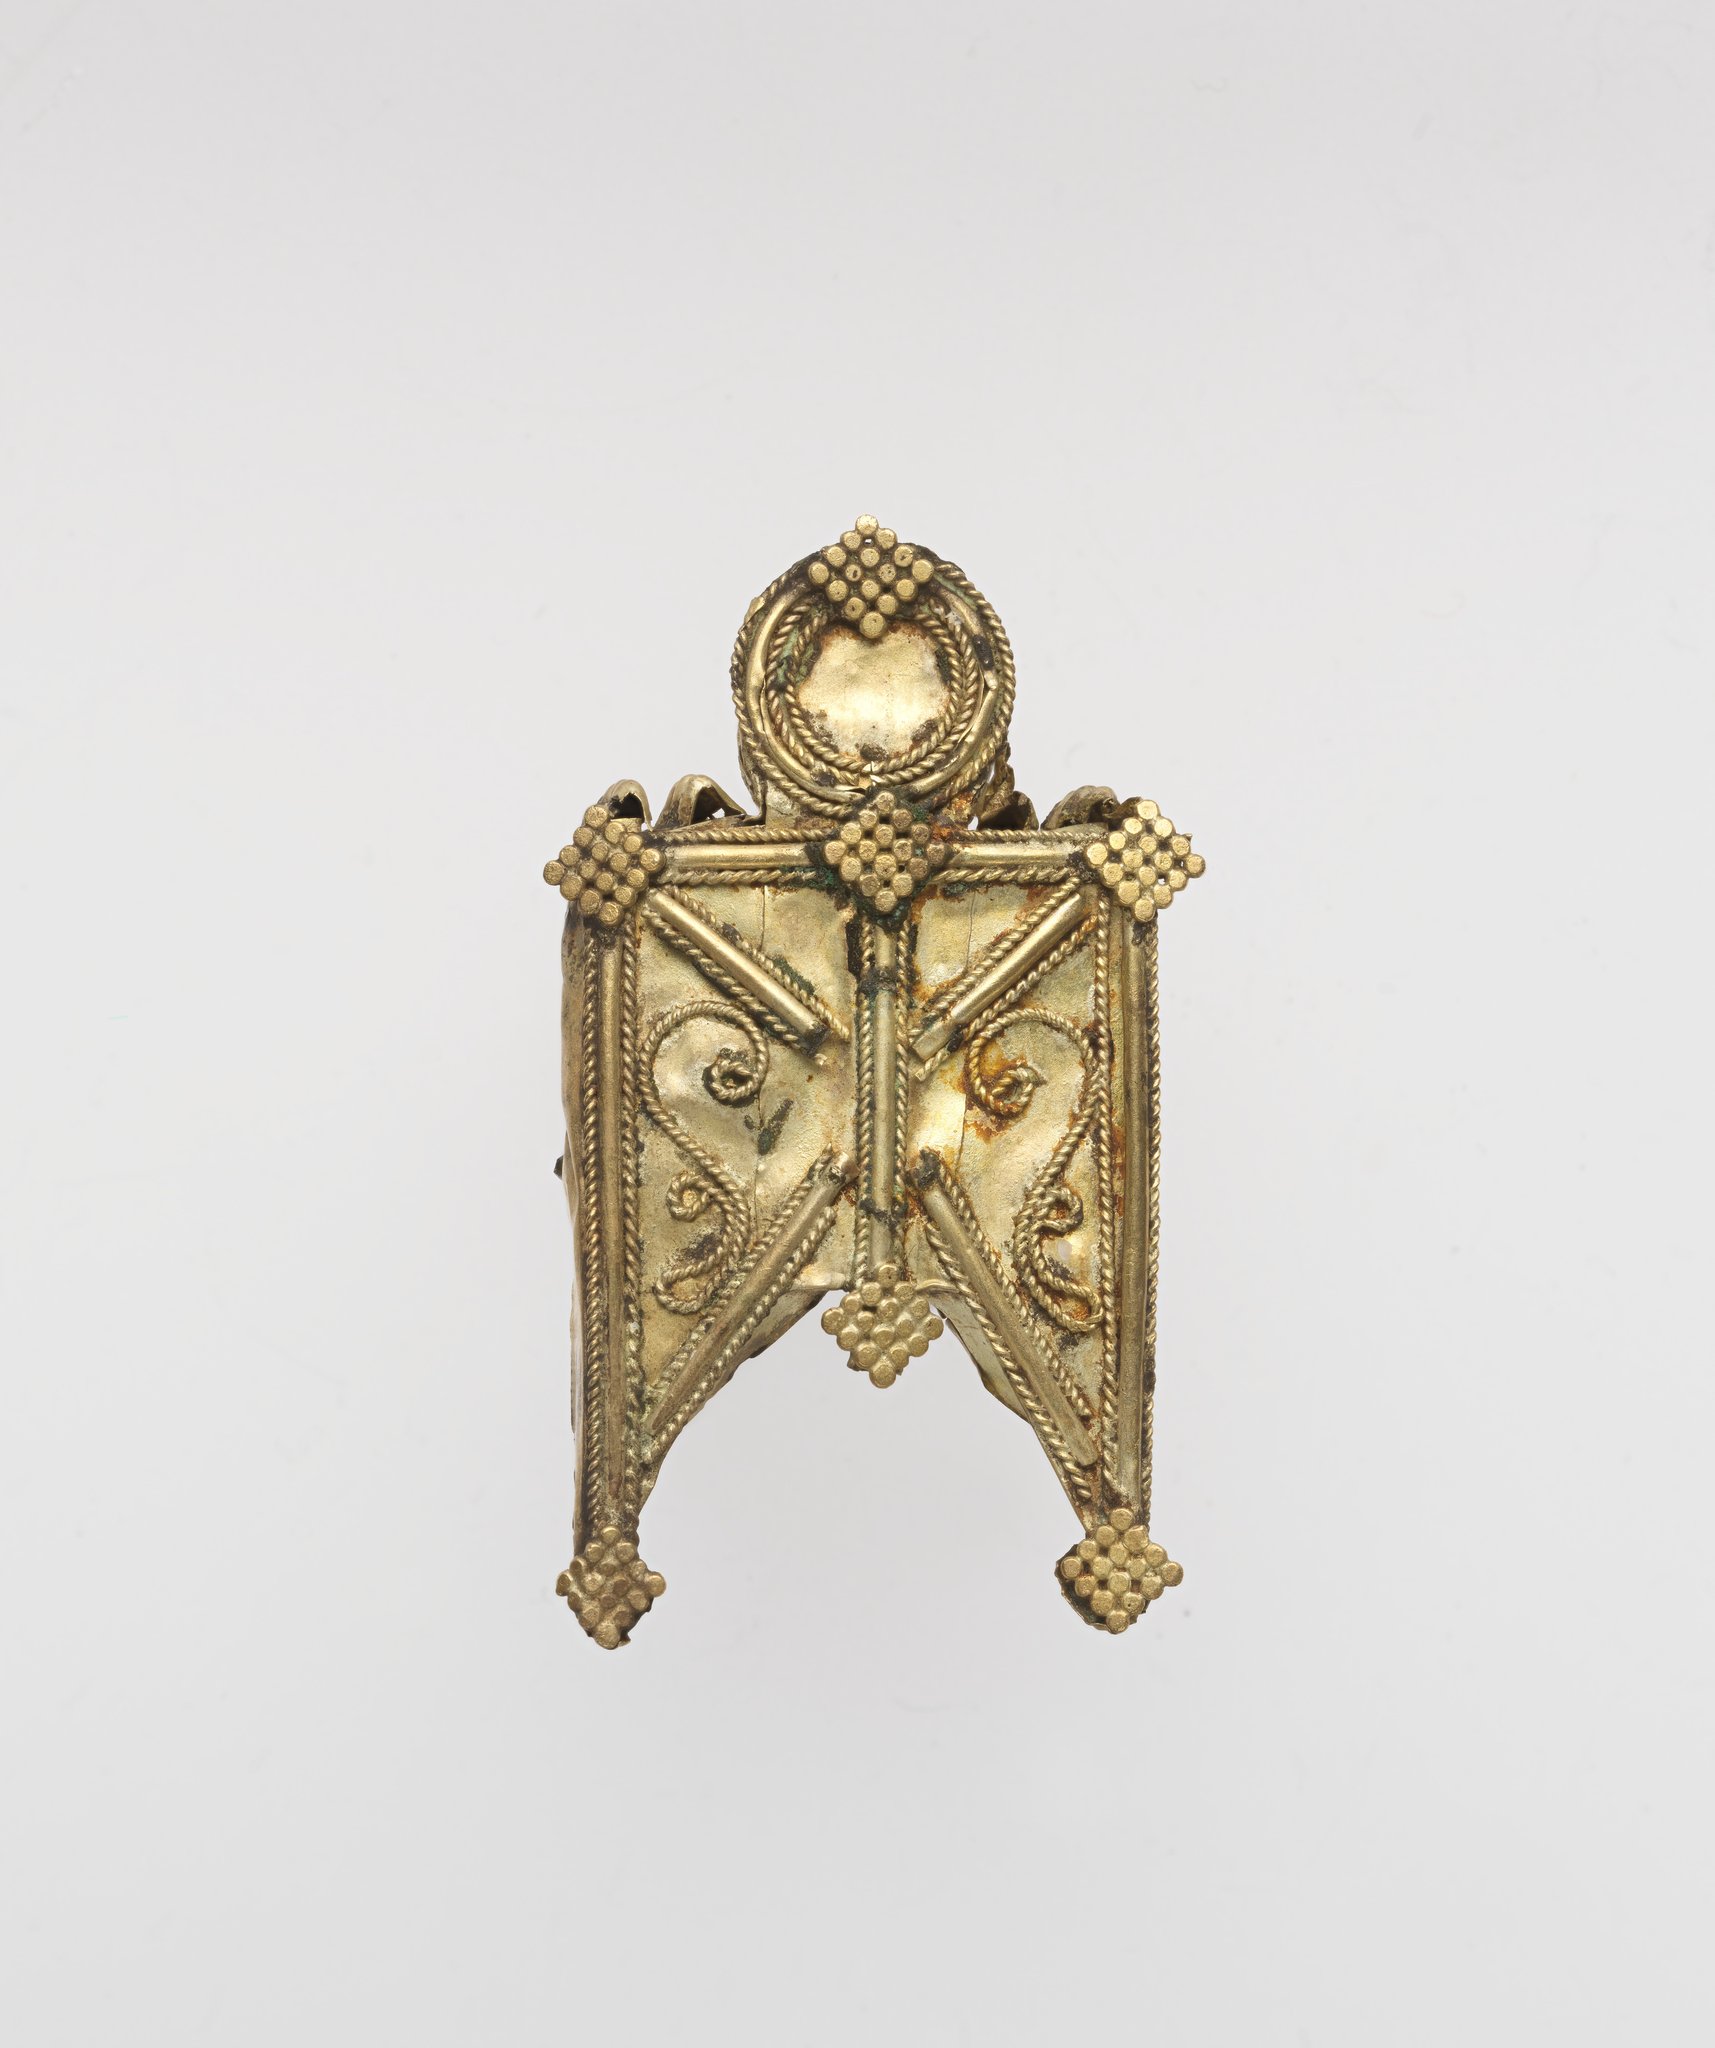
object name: jewellery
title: Marriage Pendant (Thali)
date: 1601-1900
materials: gold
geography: india